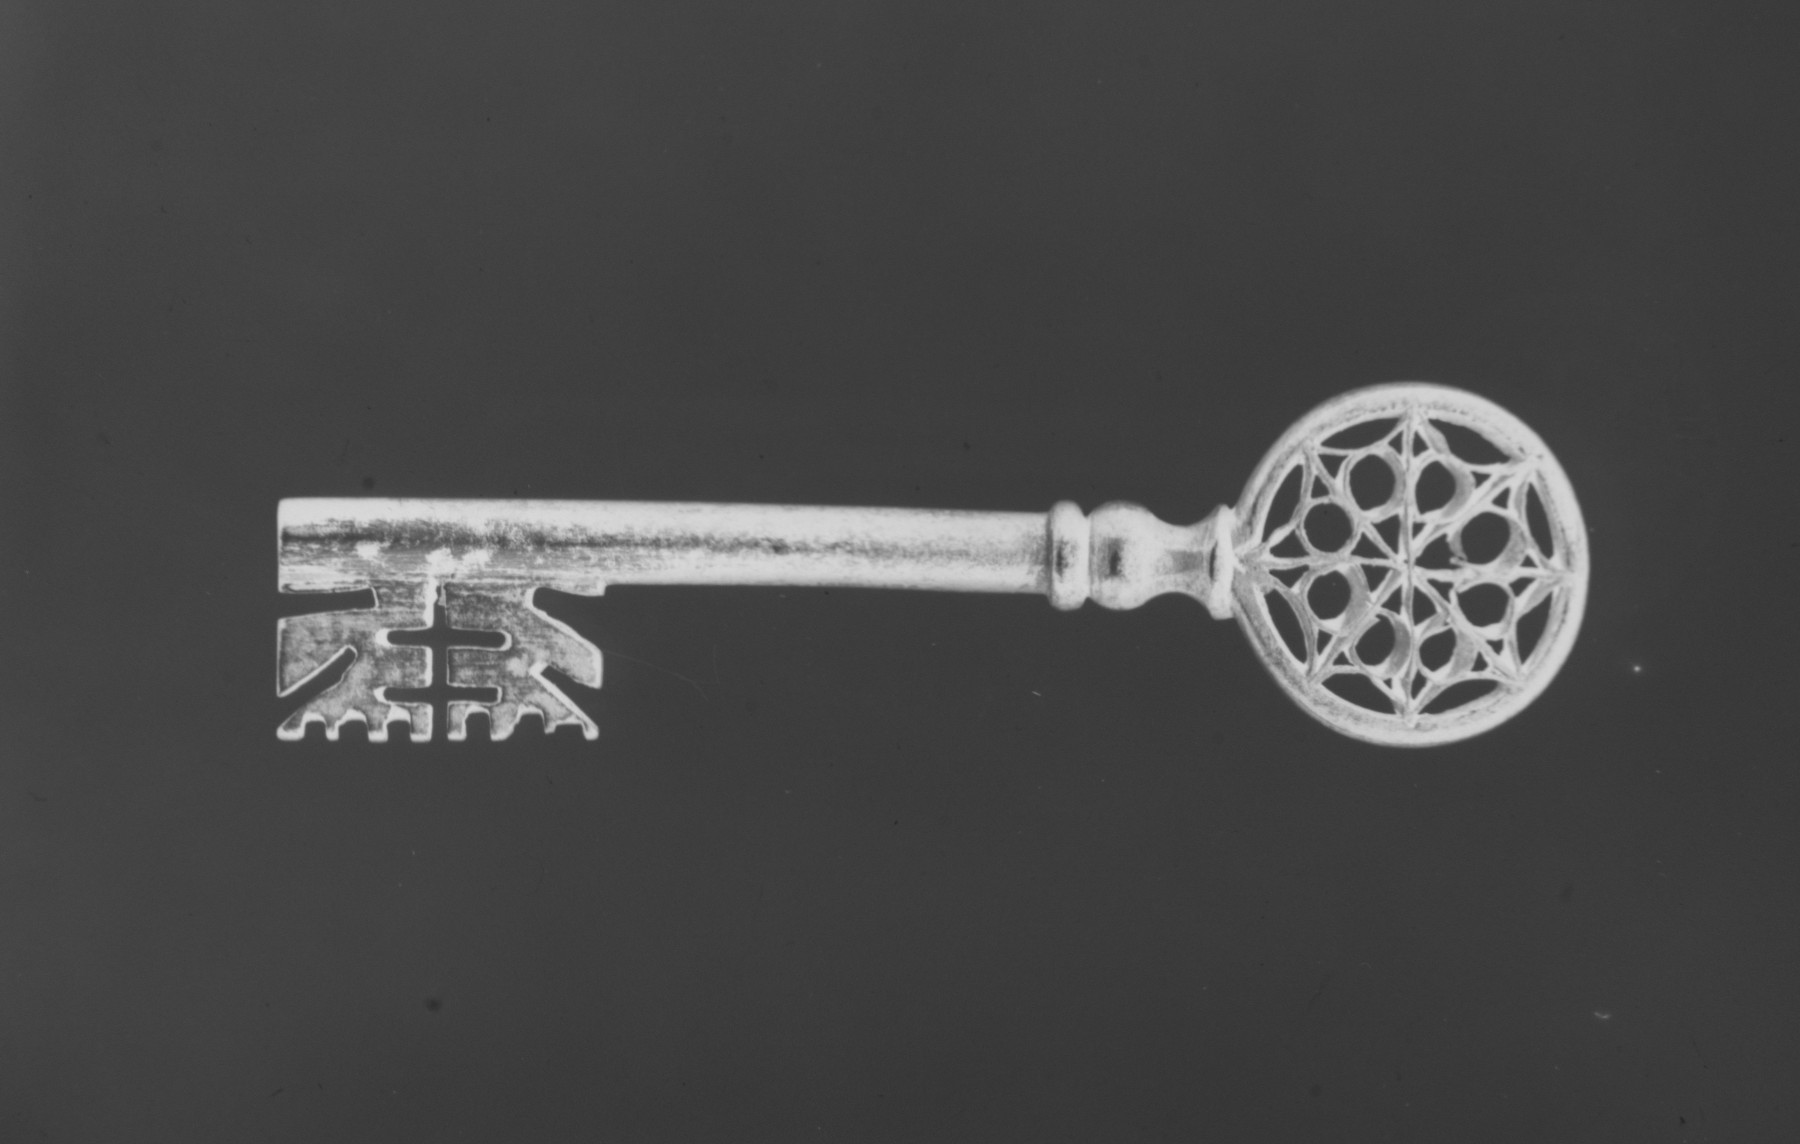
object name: coffer or chest key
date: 1567-1633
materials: iron